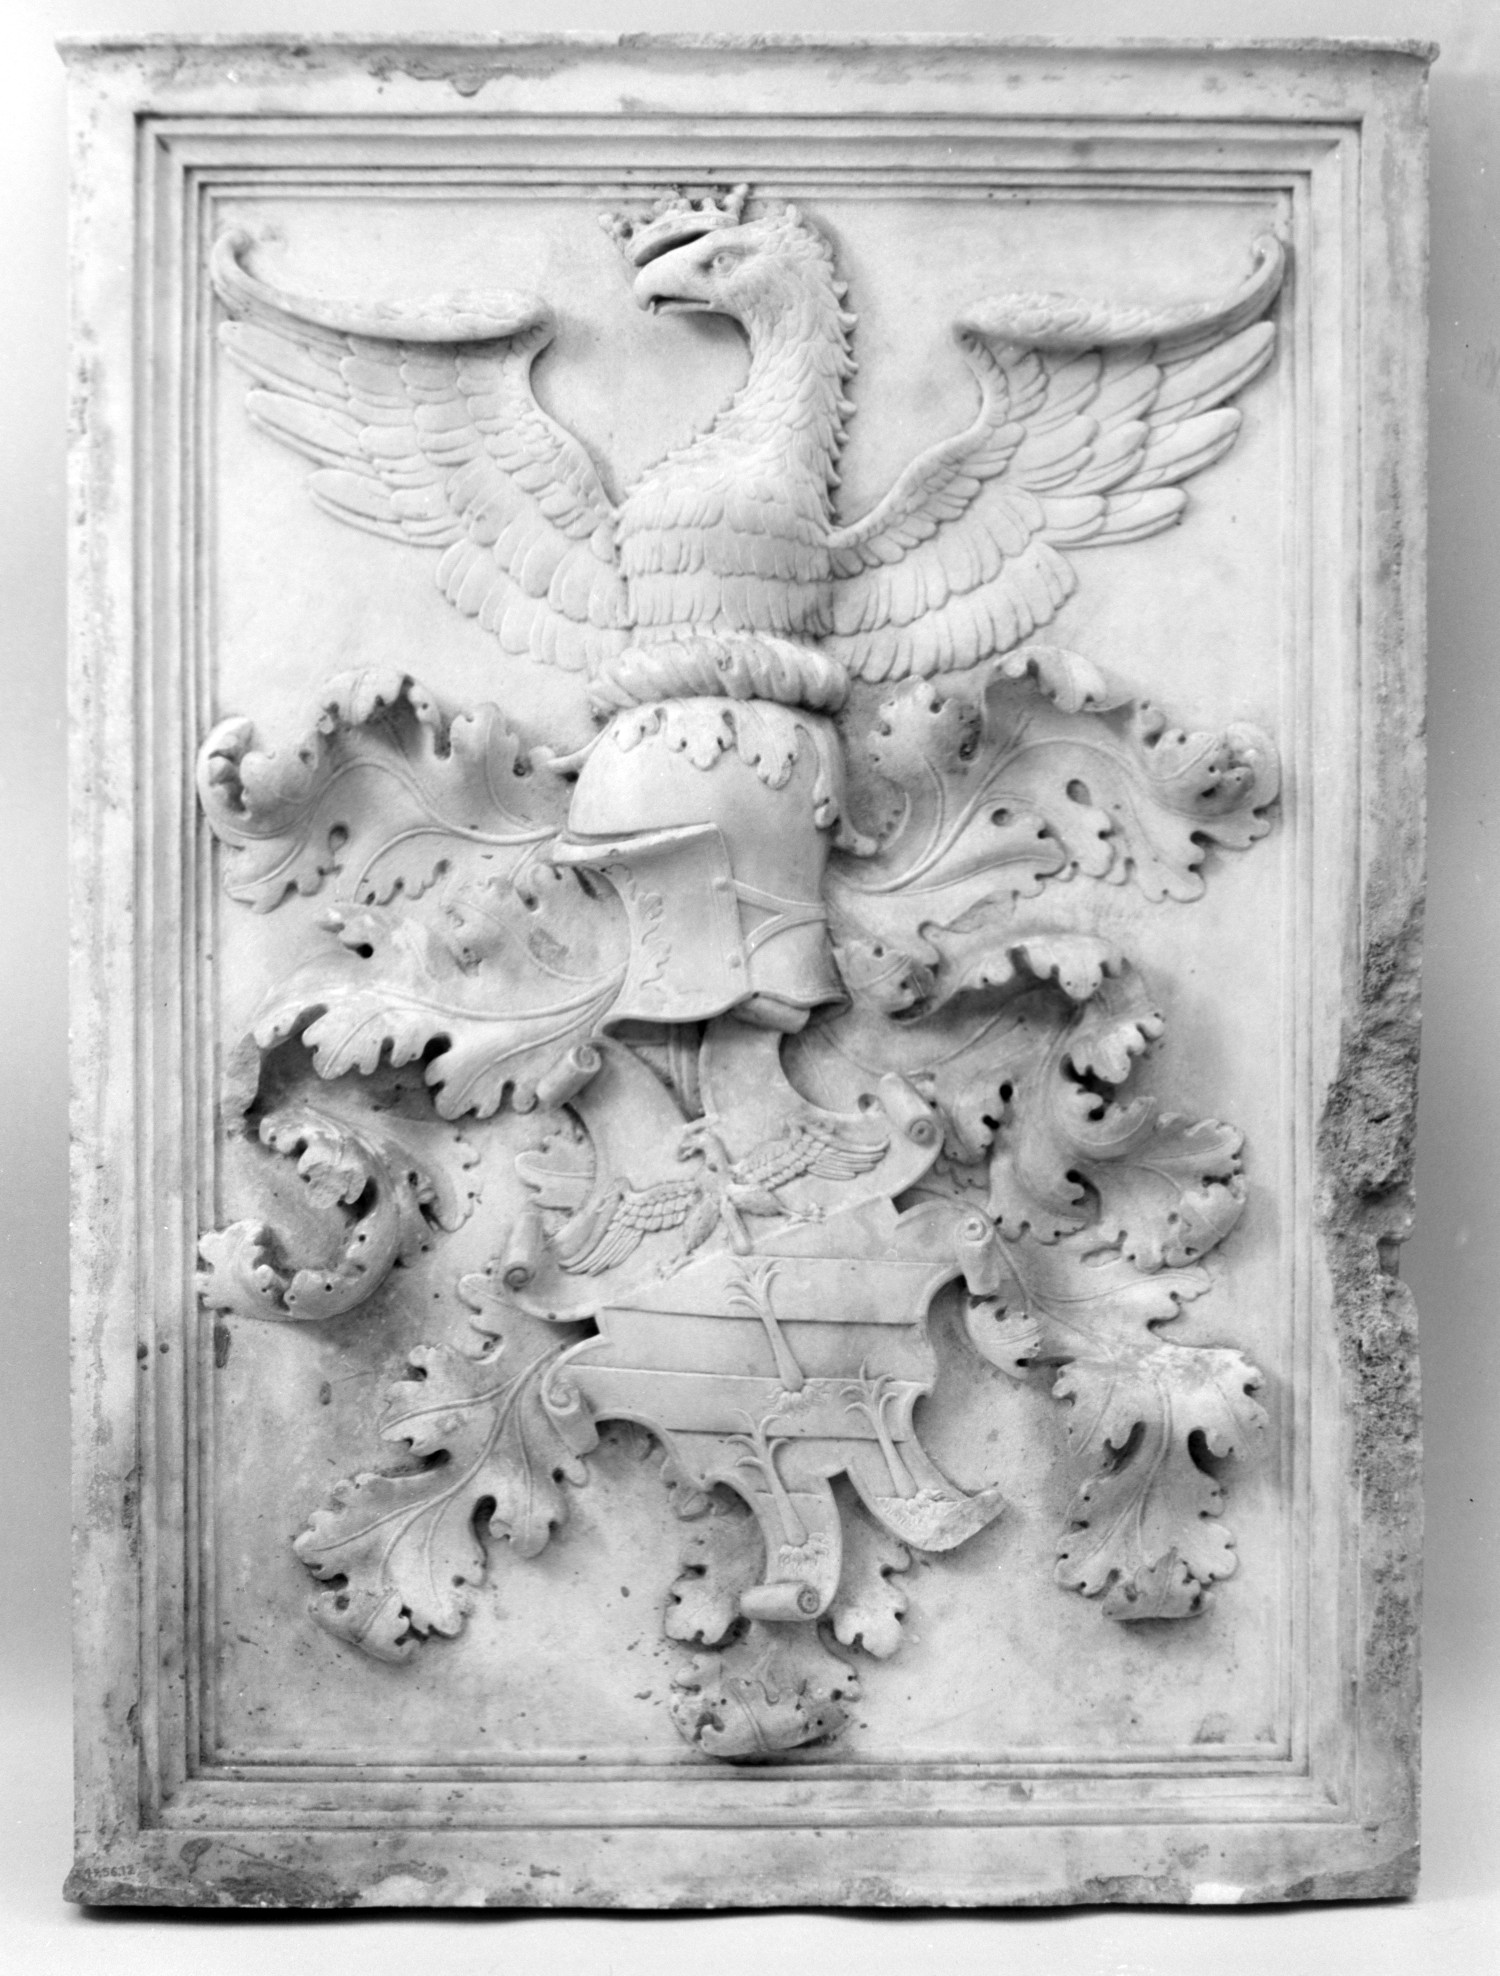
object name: armorial tablet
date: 1501-1600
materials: marble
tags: eagles,armor